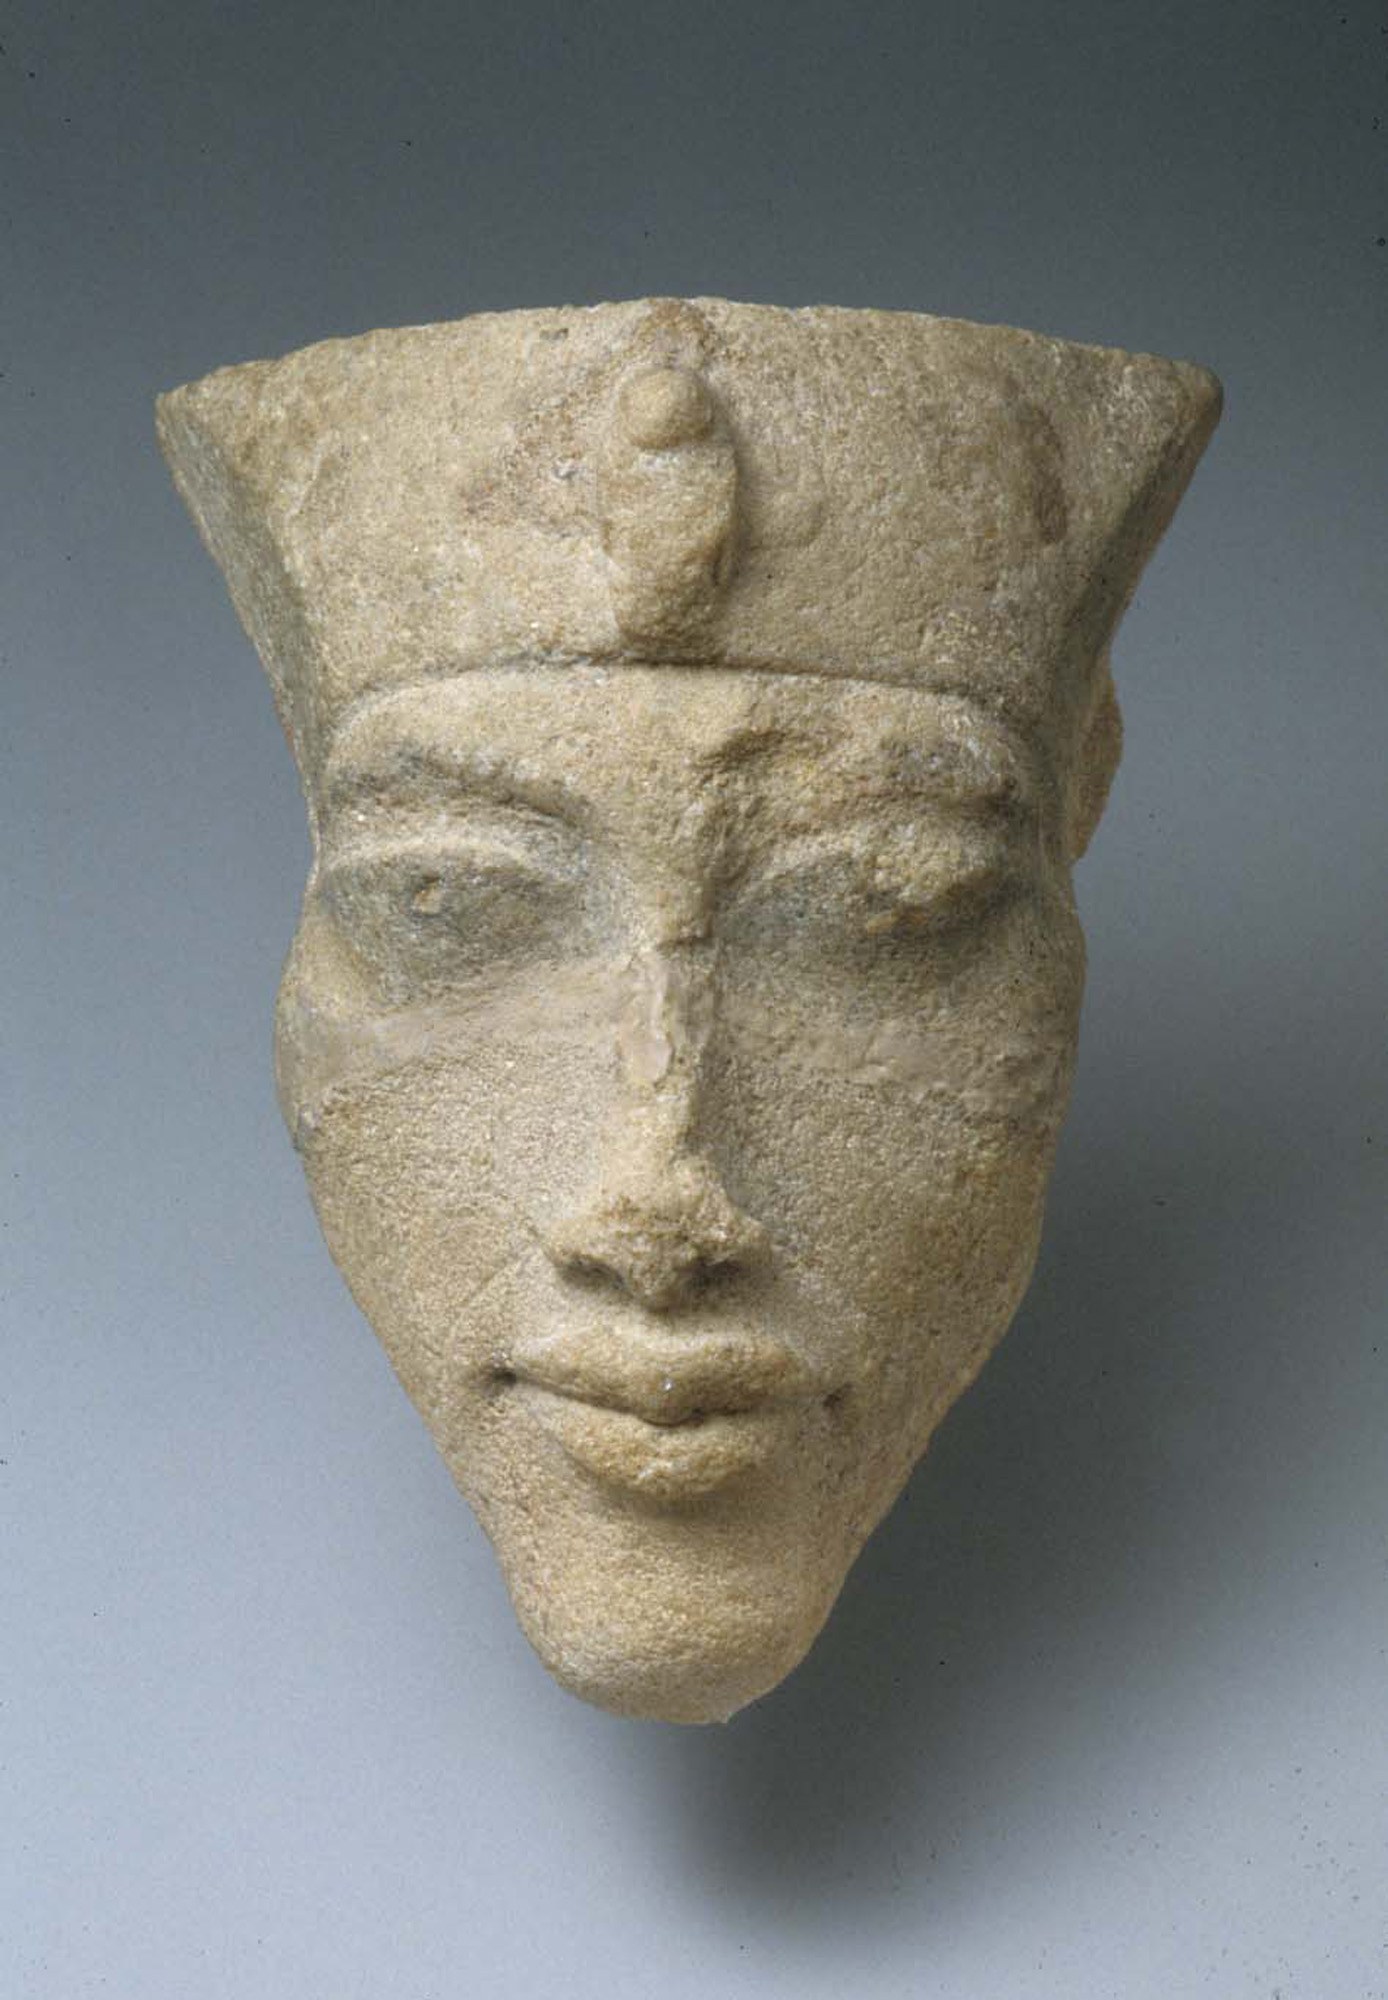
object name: head, akhenaten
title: Head of Akhenaten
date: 1353-1336 BCE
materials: stone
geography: egypt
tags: heads